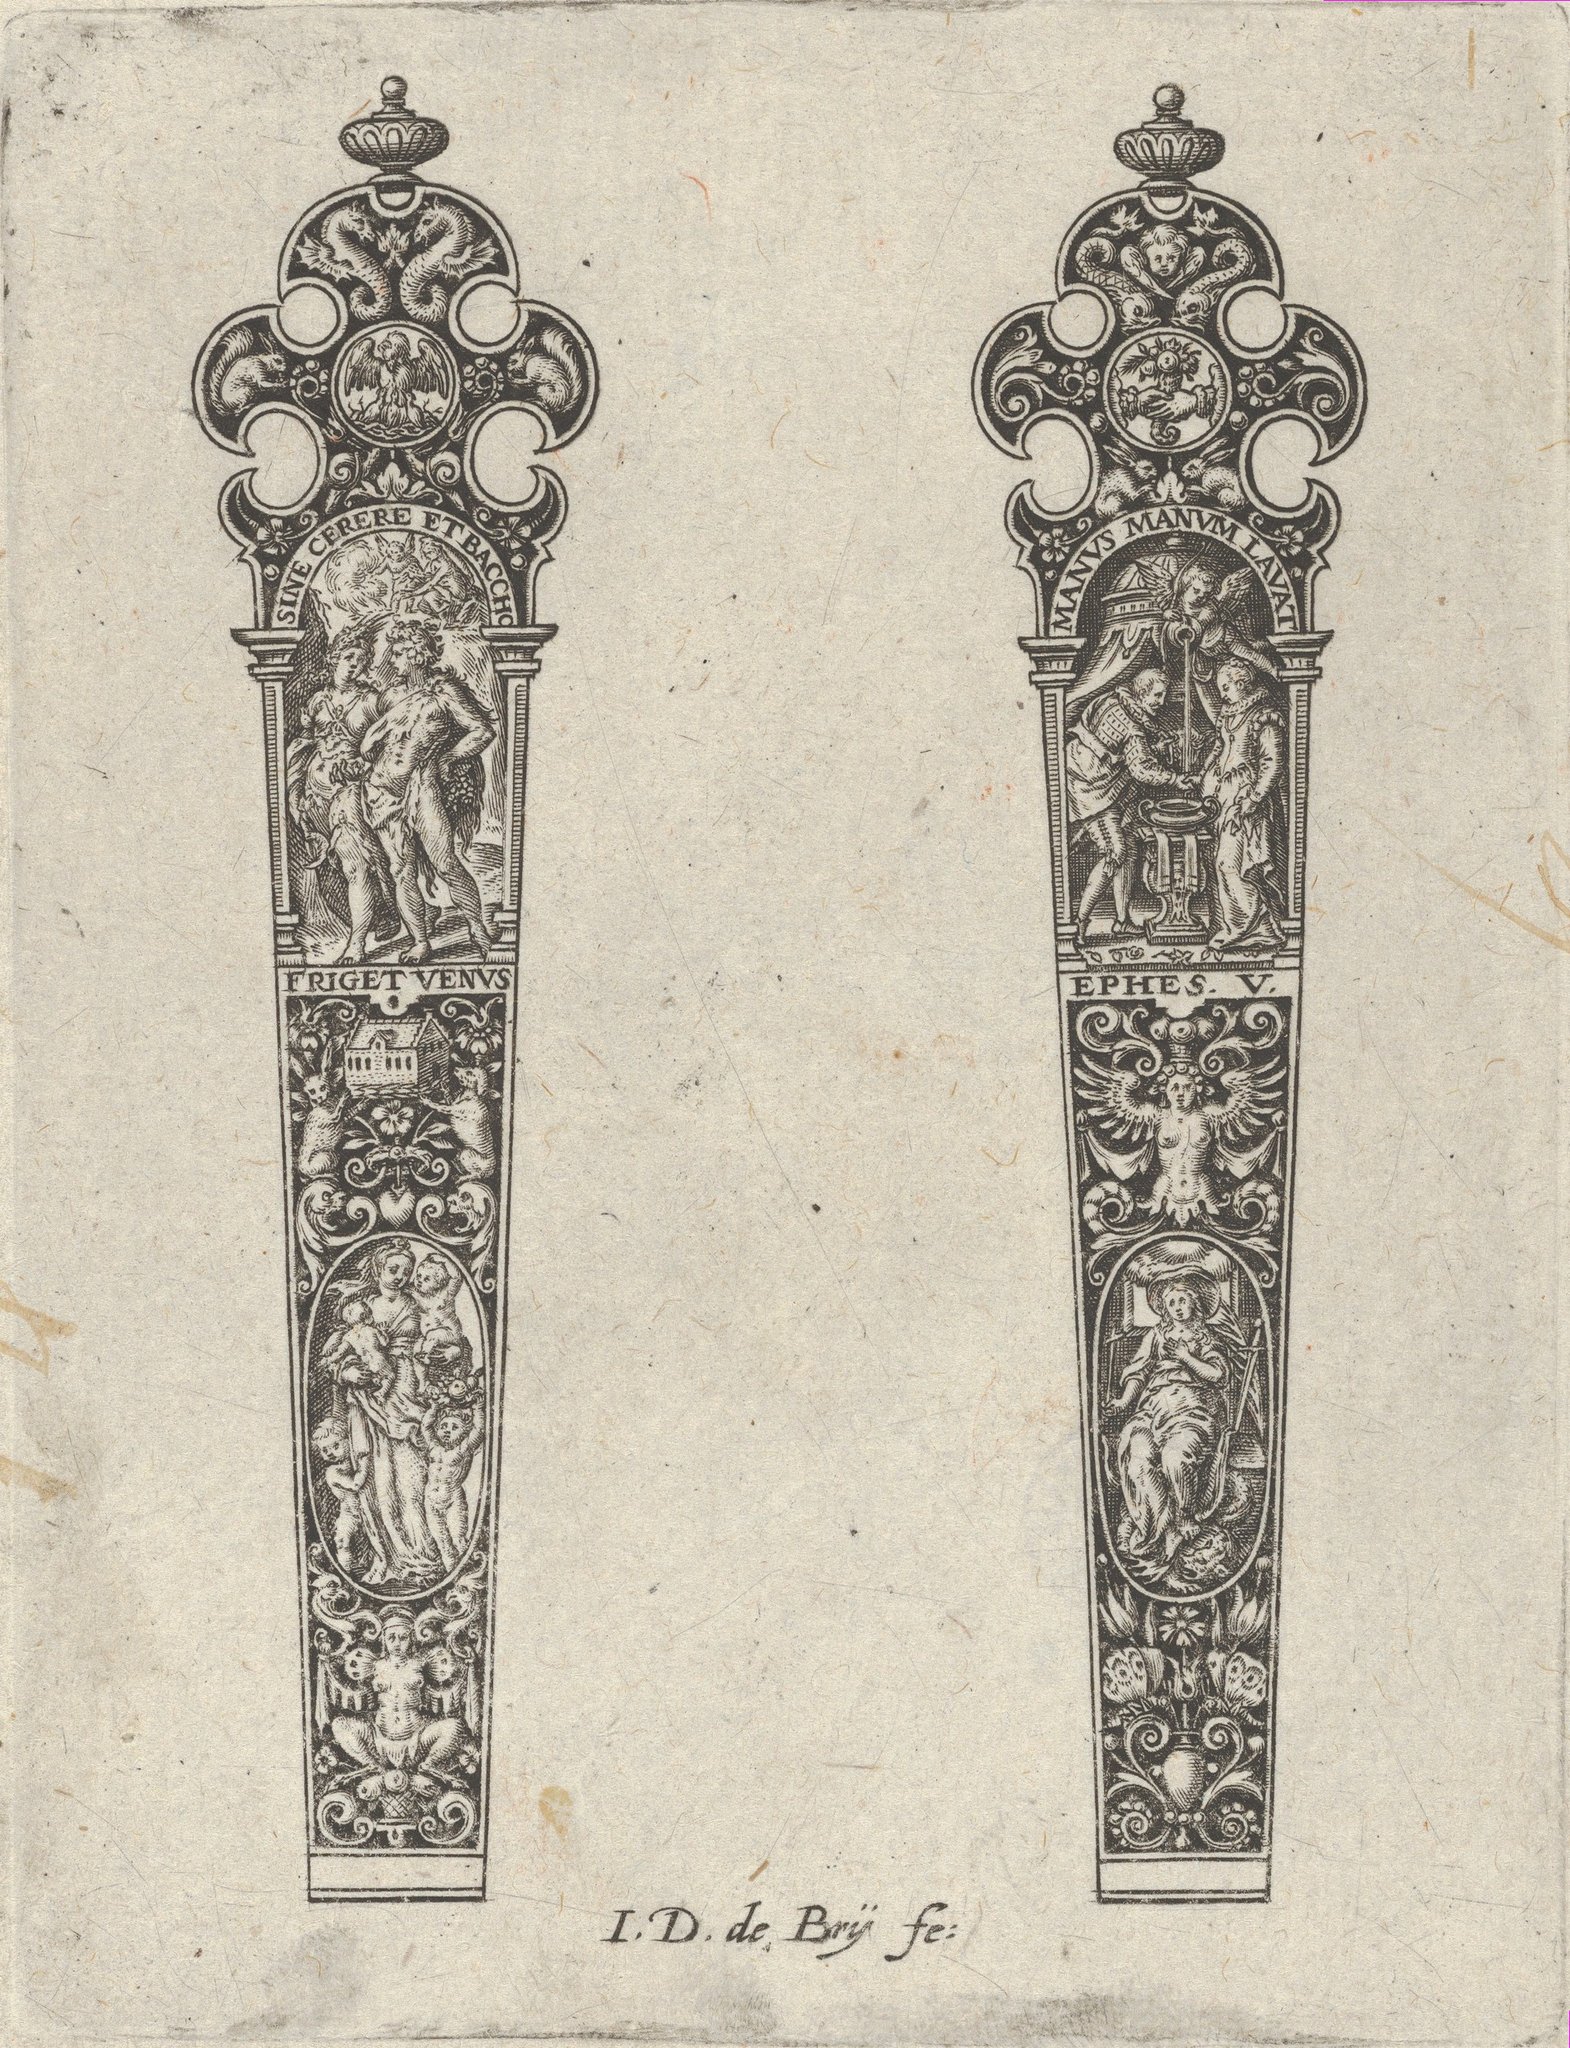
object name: print ornament architecture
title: Design for Knife Handles with 'Sine Cerere et Baccho Friget Venus' and a Couple Shaking Hands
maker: johann theodor de bry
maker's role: artist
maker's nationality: netherlandish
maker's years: 1561-1623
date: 1580-1600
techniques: embroidery, engraving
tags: ornament